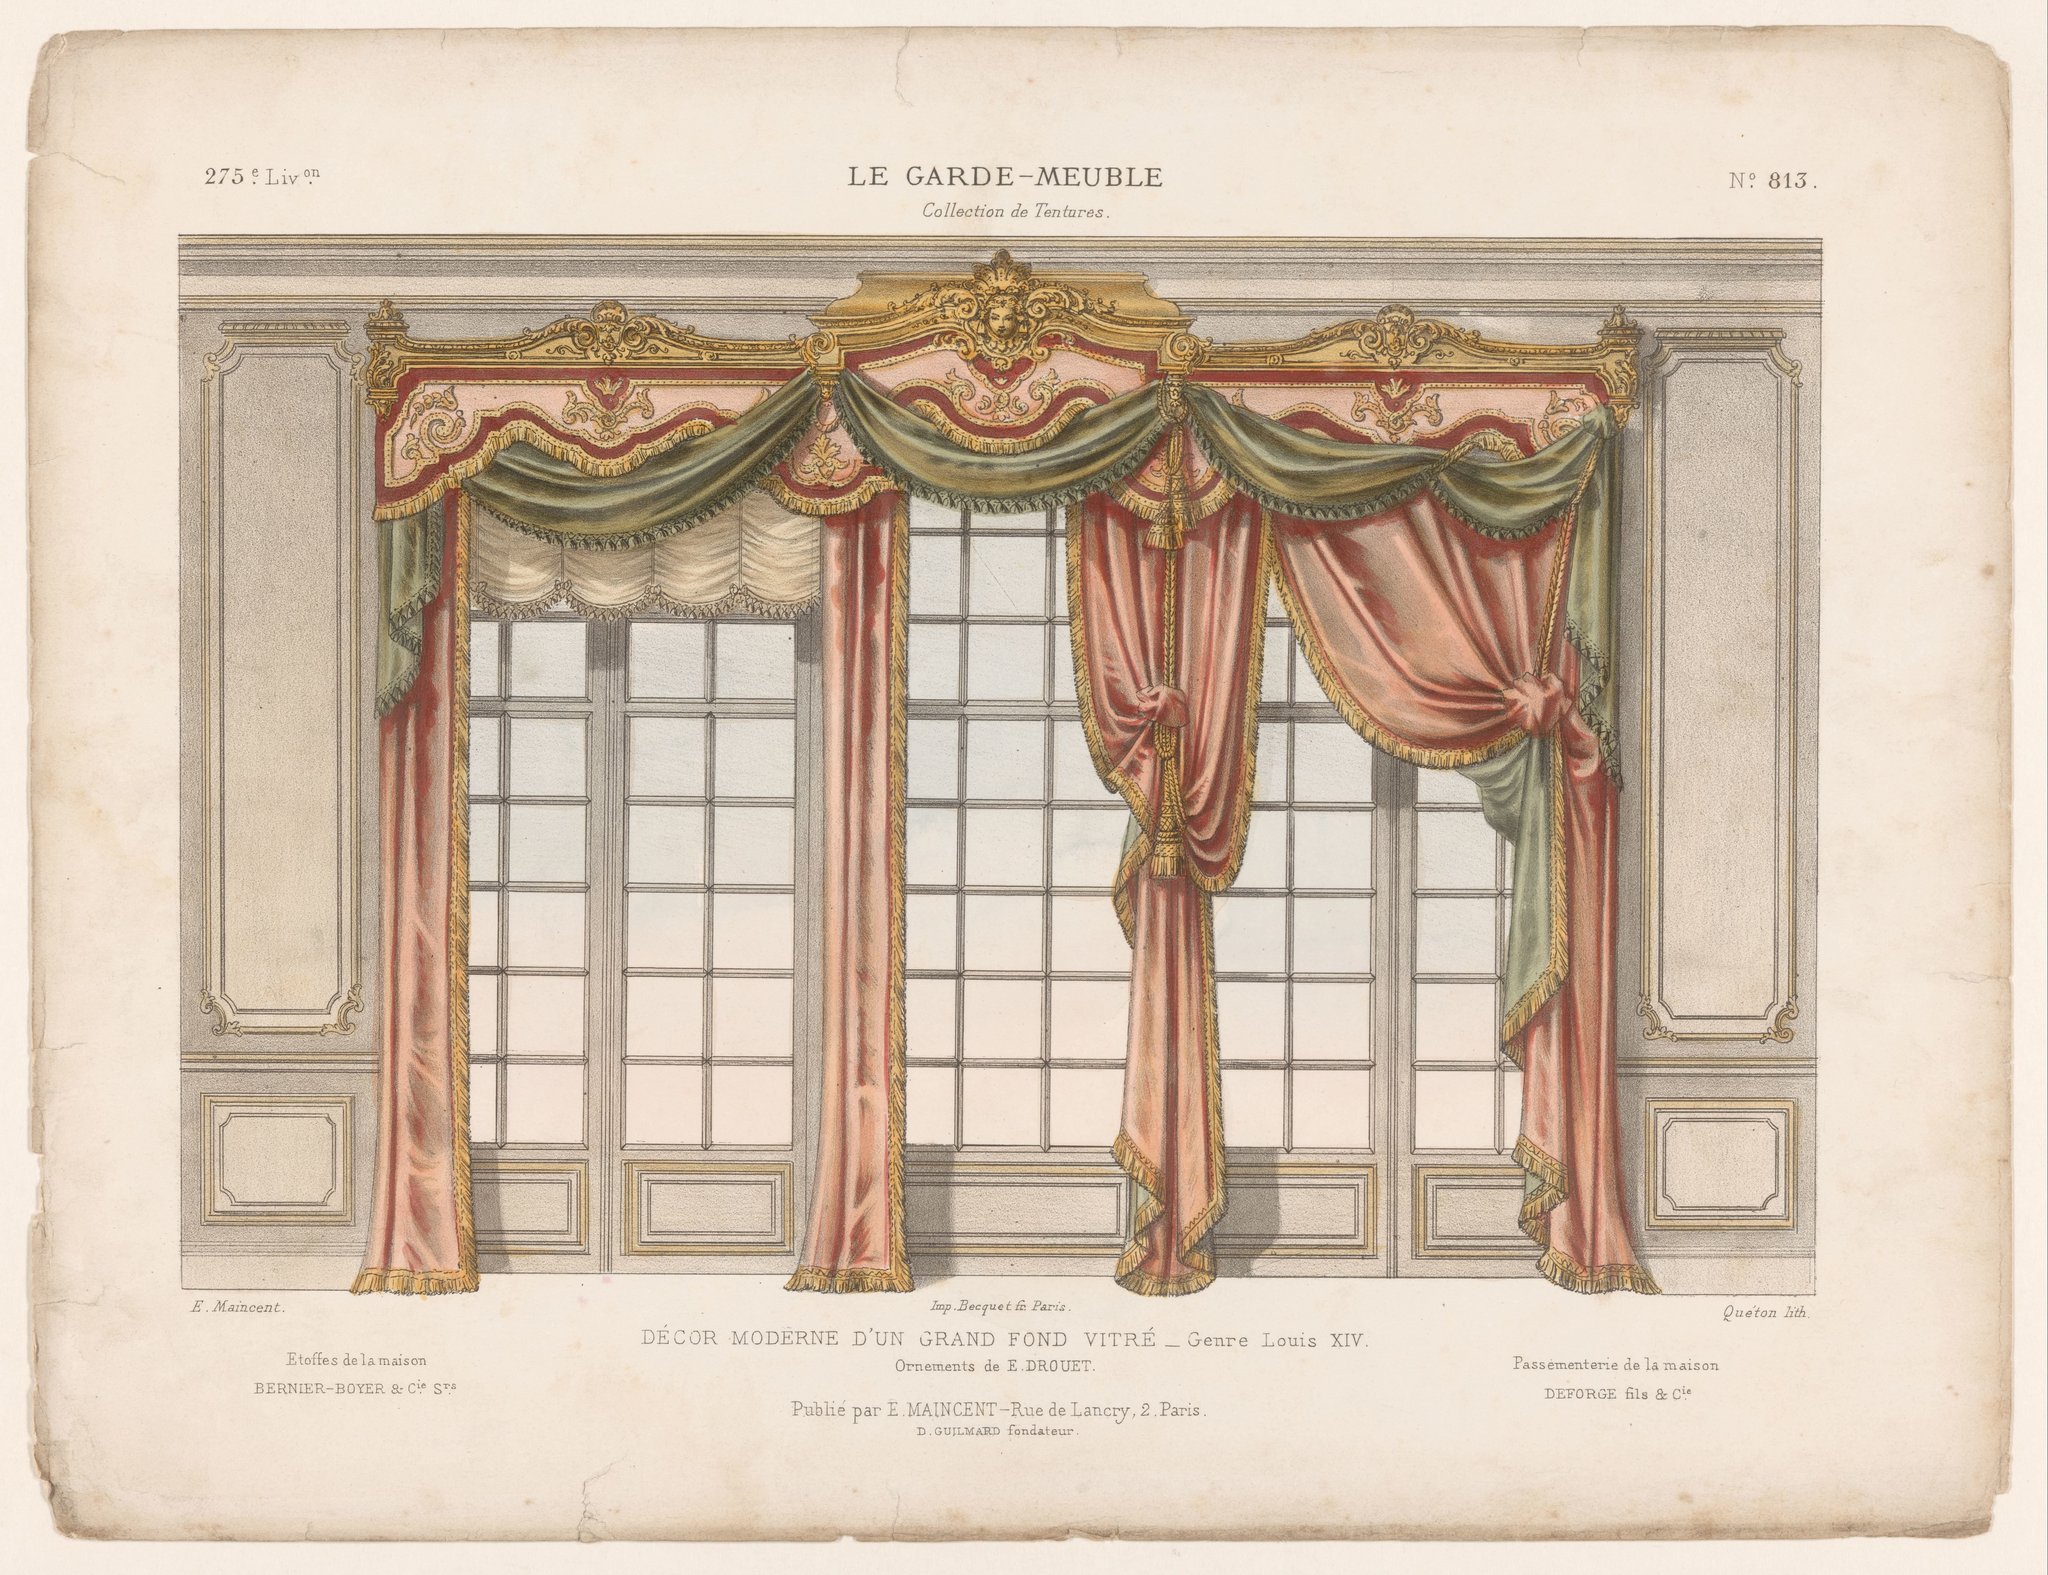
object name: print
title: Le Garde-Meuble / Collection de Tentures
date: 1885-1895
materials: paper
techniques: hand coloring, lithograph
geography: paris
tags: window, hangings and drapery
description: Grote raampartij met gedrapeerde gordijnen in de Lodewijk XIV-stijl. Prent uit 275e Livraison.